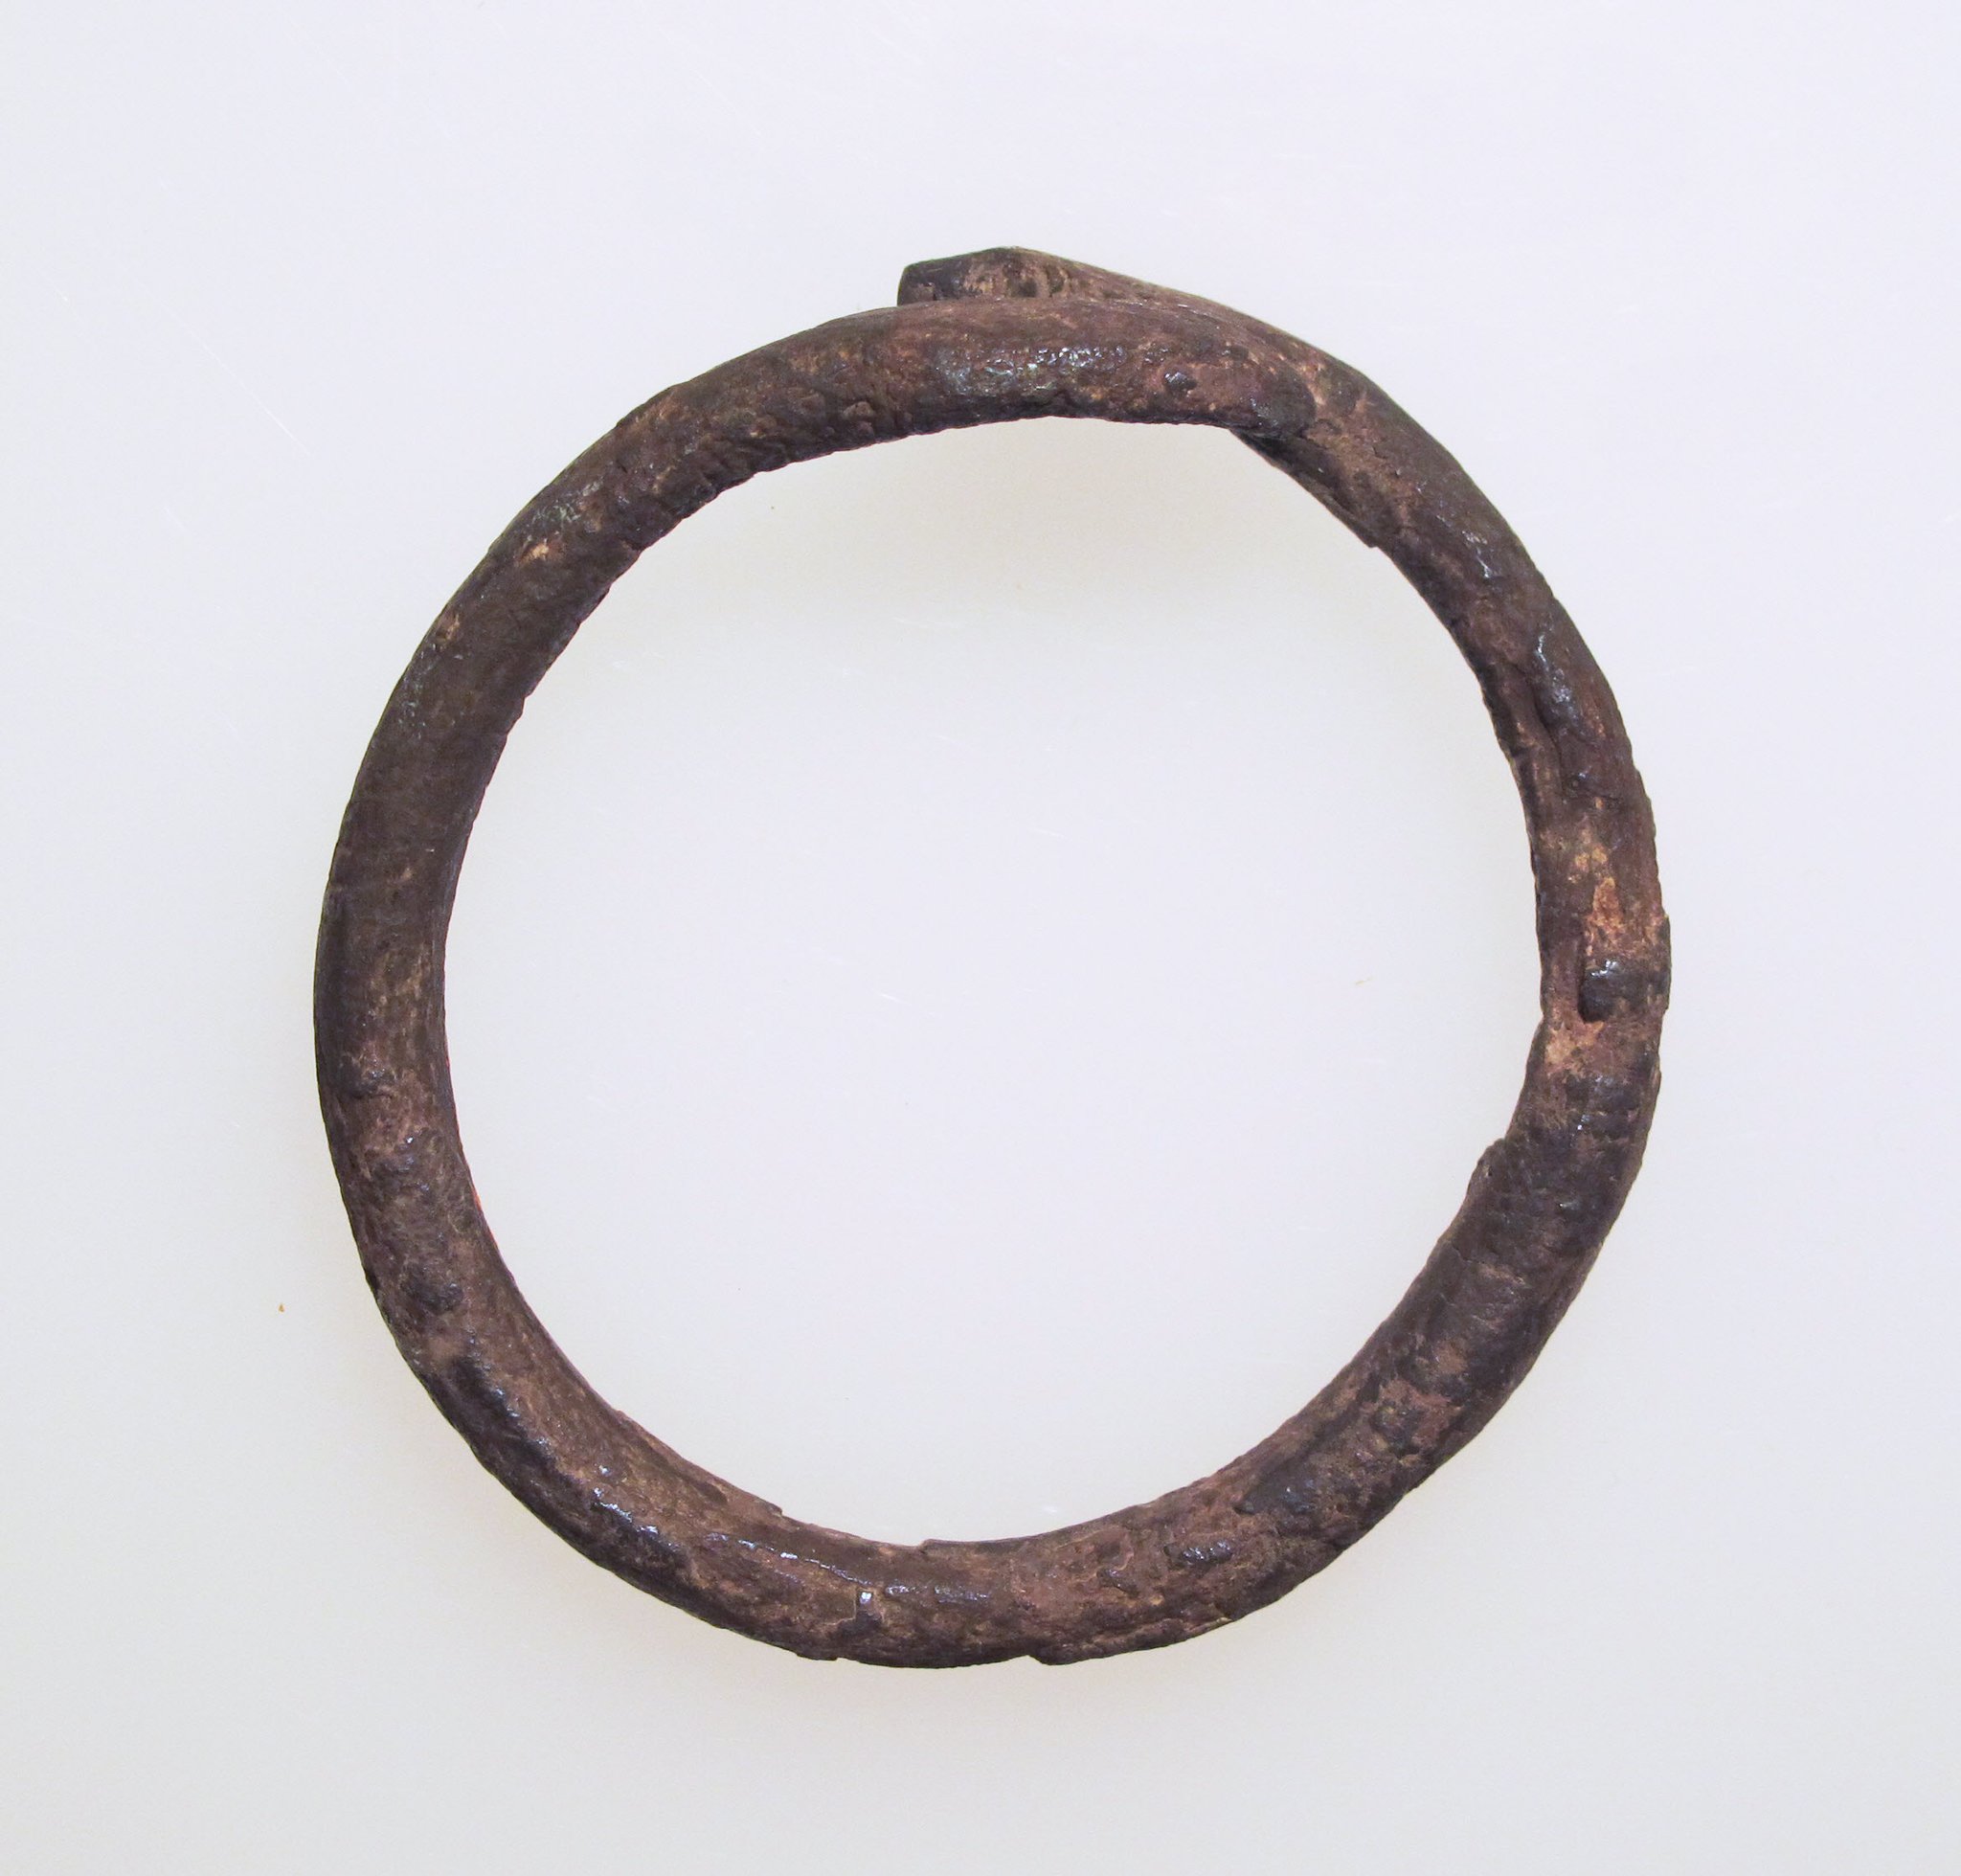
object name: bracelet with snakes' head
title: Bracelet with snakes' heads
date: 7000 BCE-330 CE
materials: silver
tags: snakes